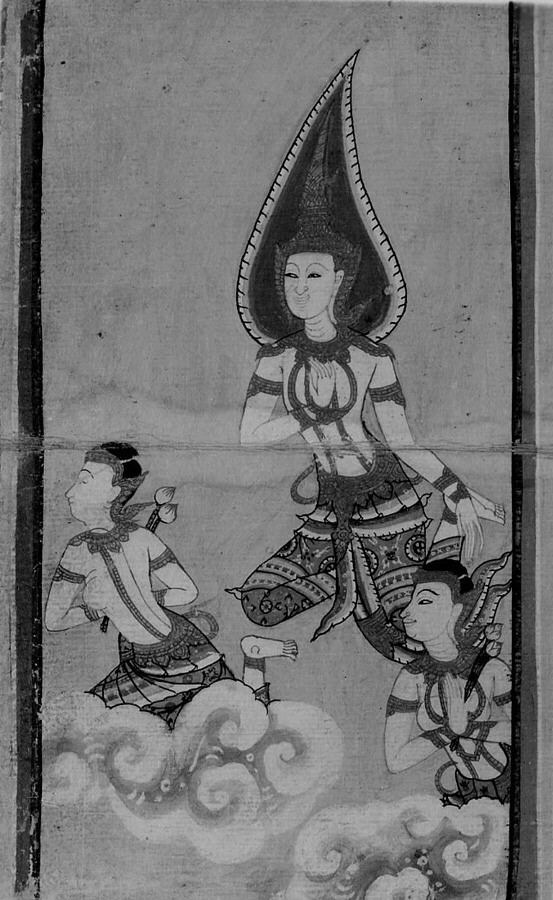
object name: manuscript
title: Illustrated Manuscript of Episodes from The Life of Phra Malai, a Follower of Buddha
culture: thai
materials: ink, paper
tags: buddhism